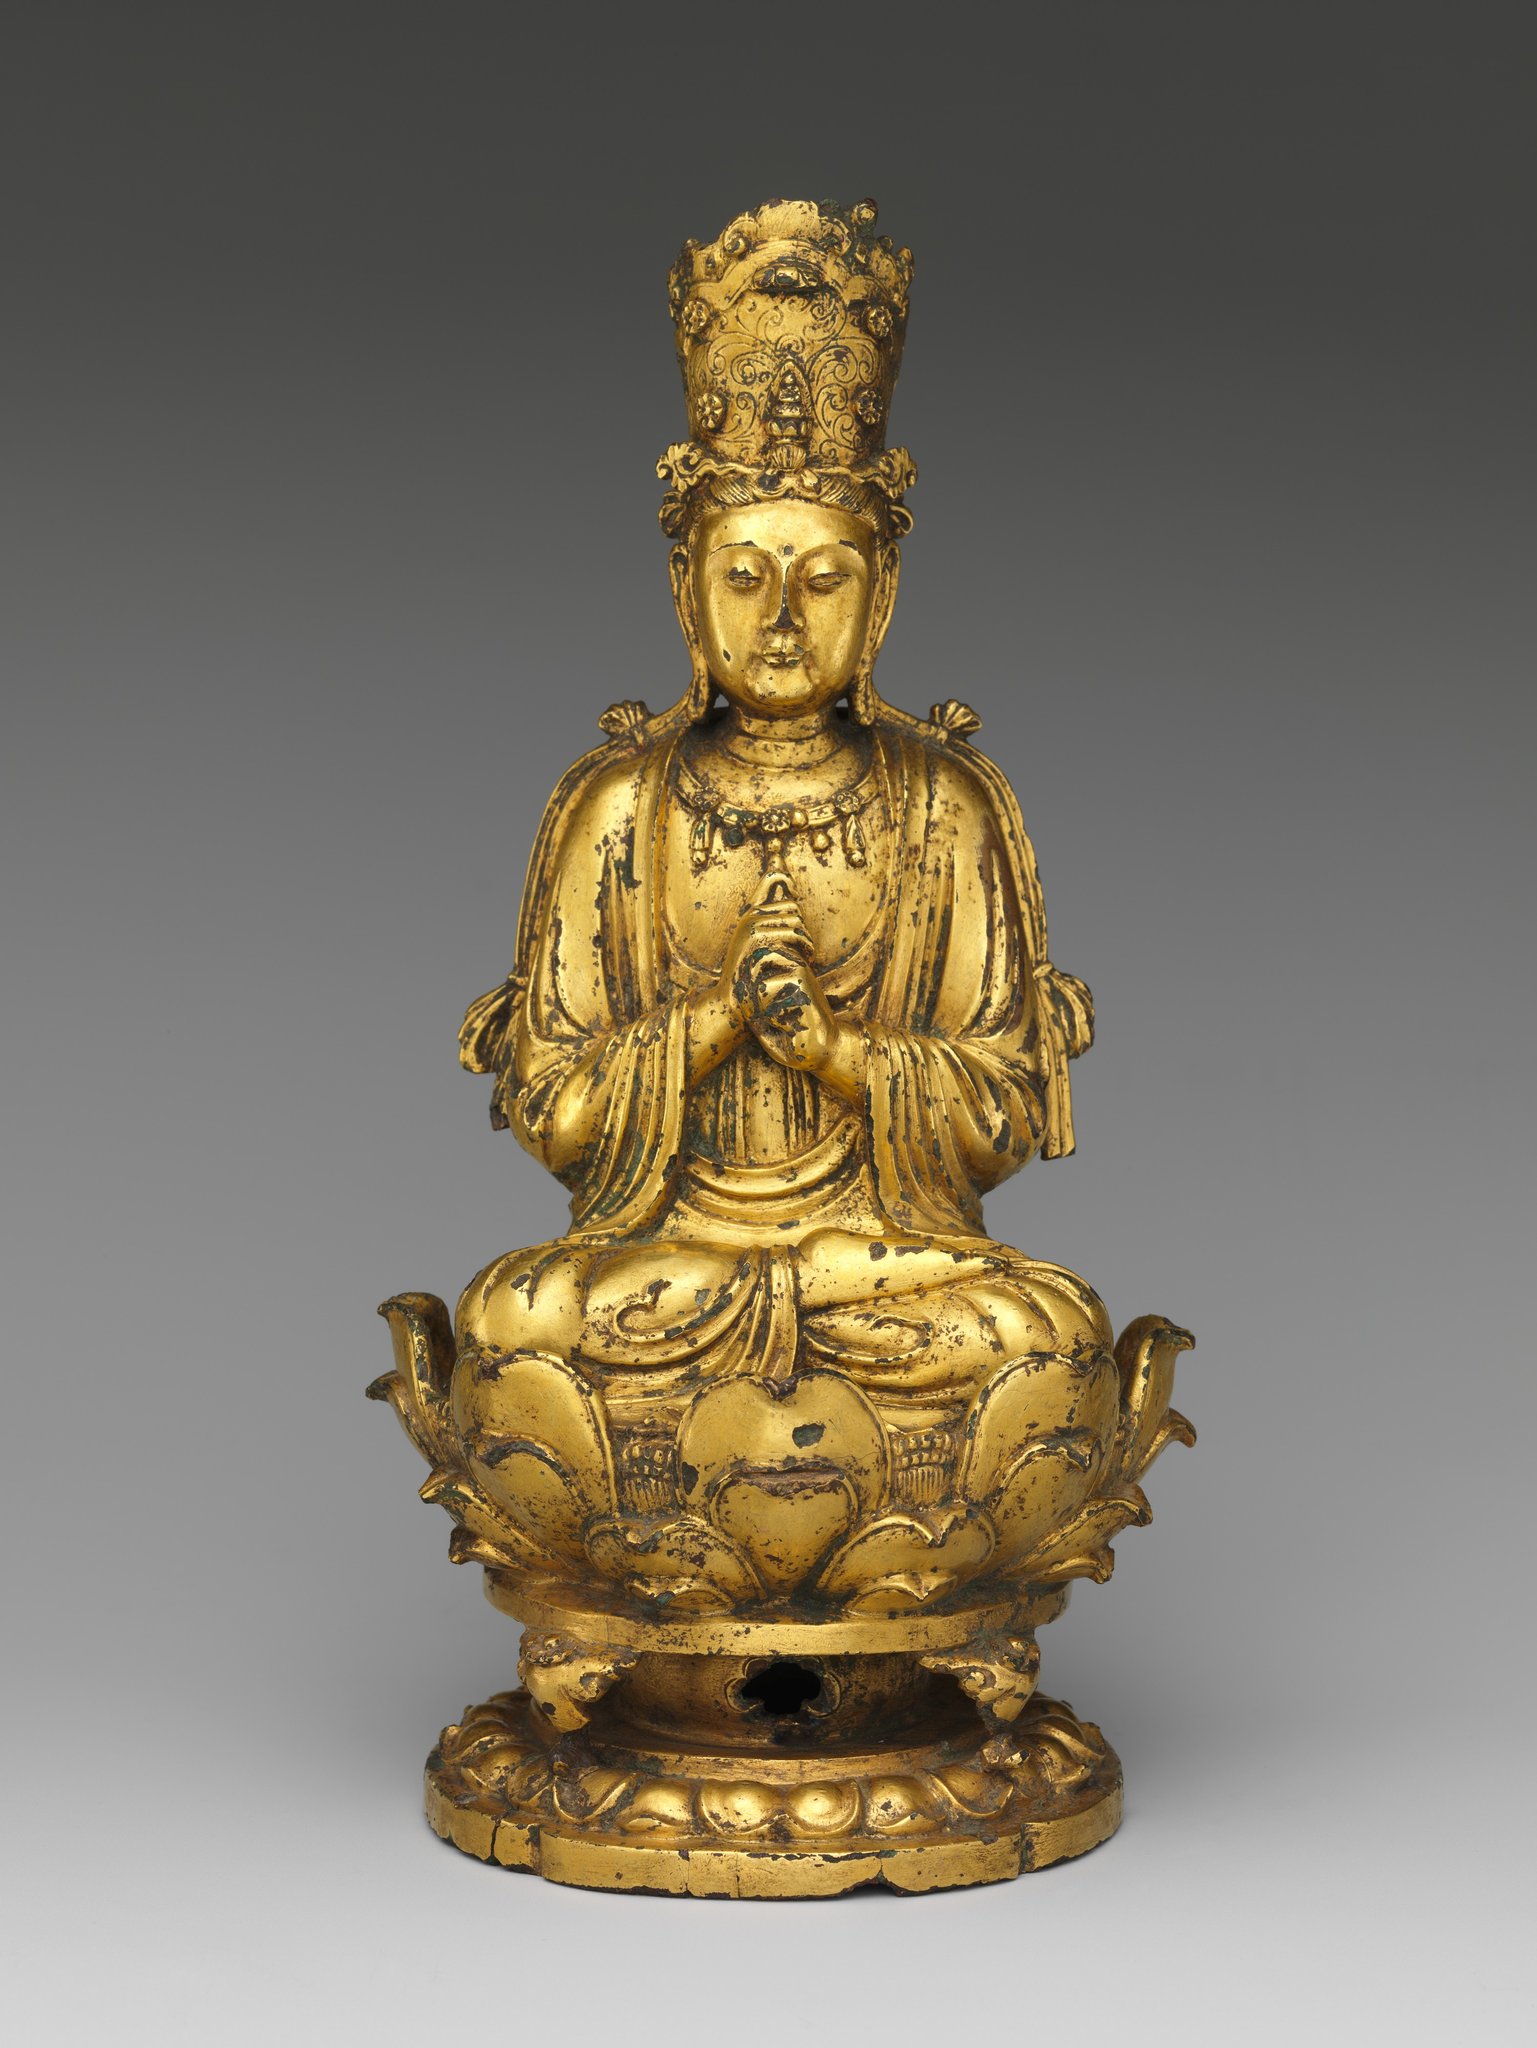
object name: figure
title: Buddha Vairocana (Dari)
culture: chinese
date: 1001-1100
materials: gilt bronze, wax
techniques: casting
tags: lotuses,buddhism,buddha